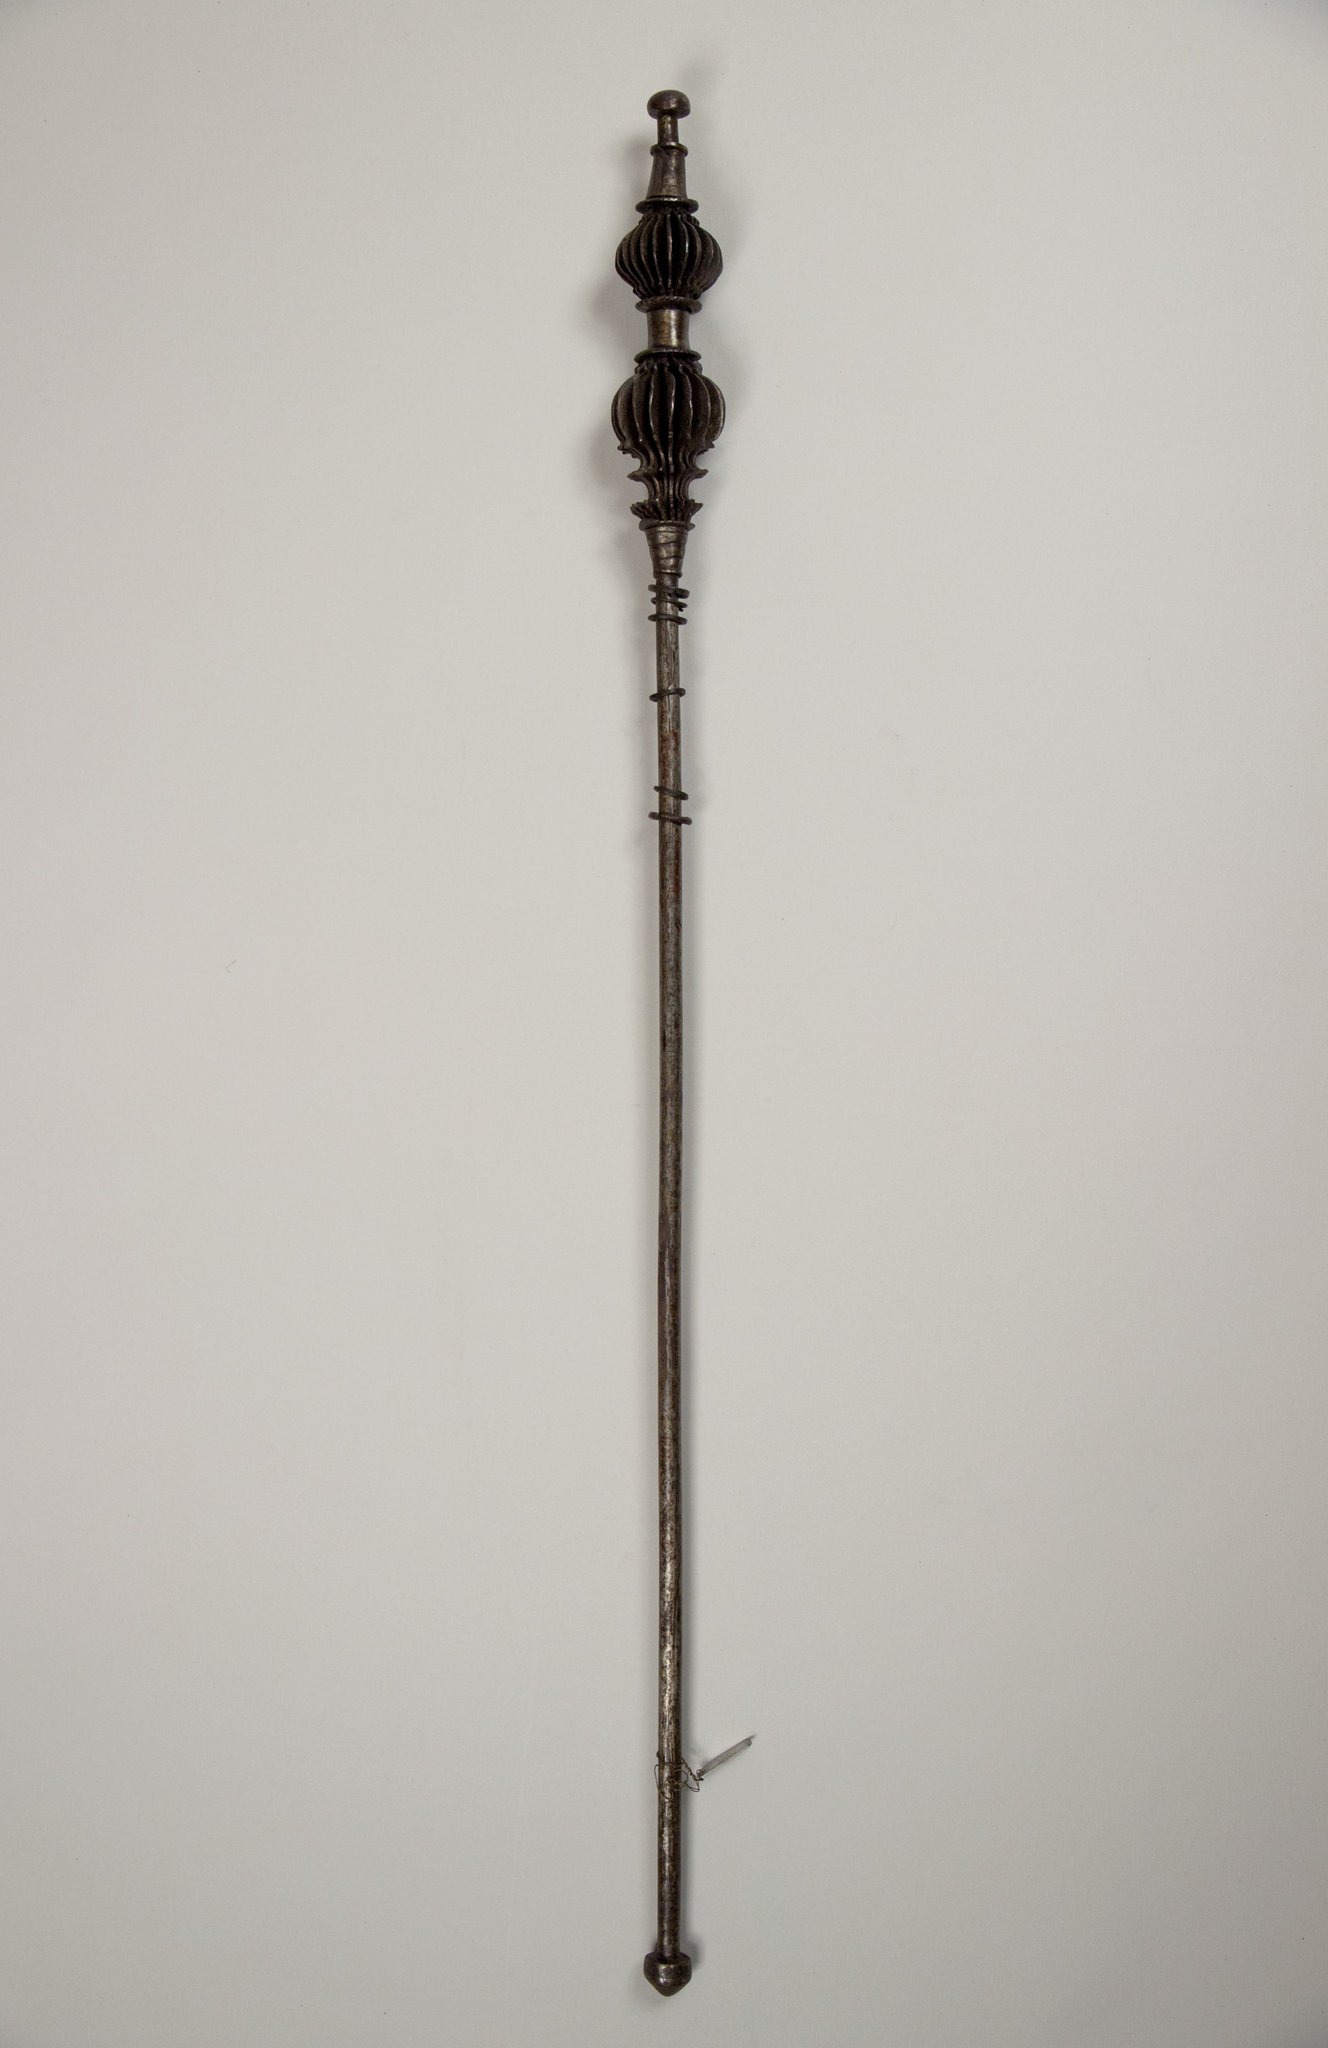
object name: mace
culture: north indian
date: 1601-1700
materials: steel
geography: india